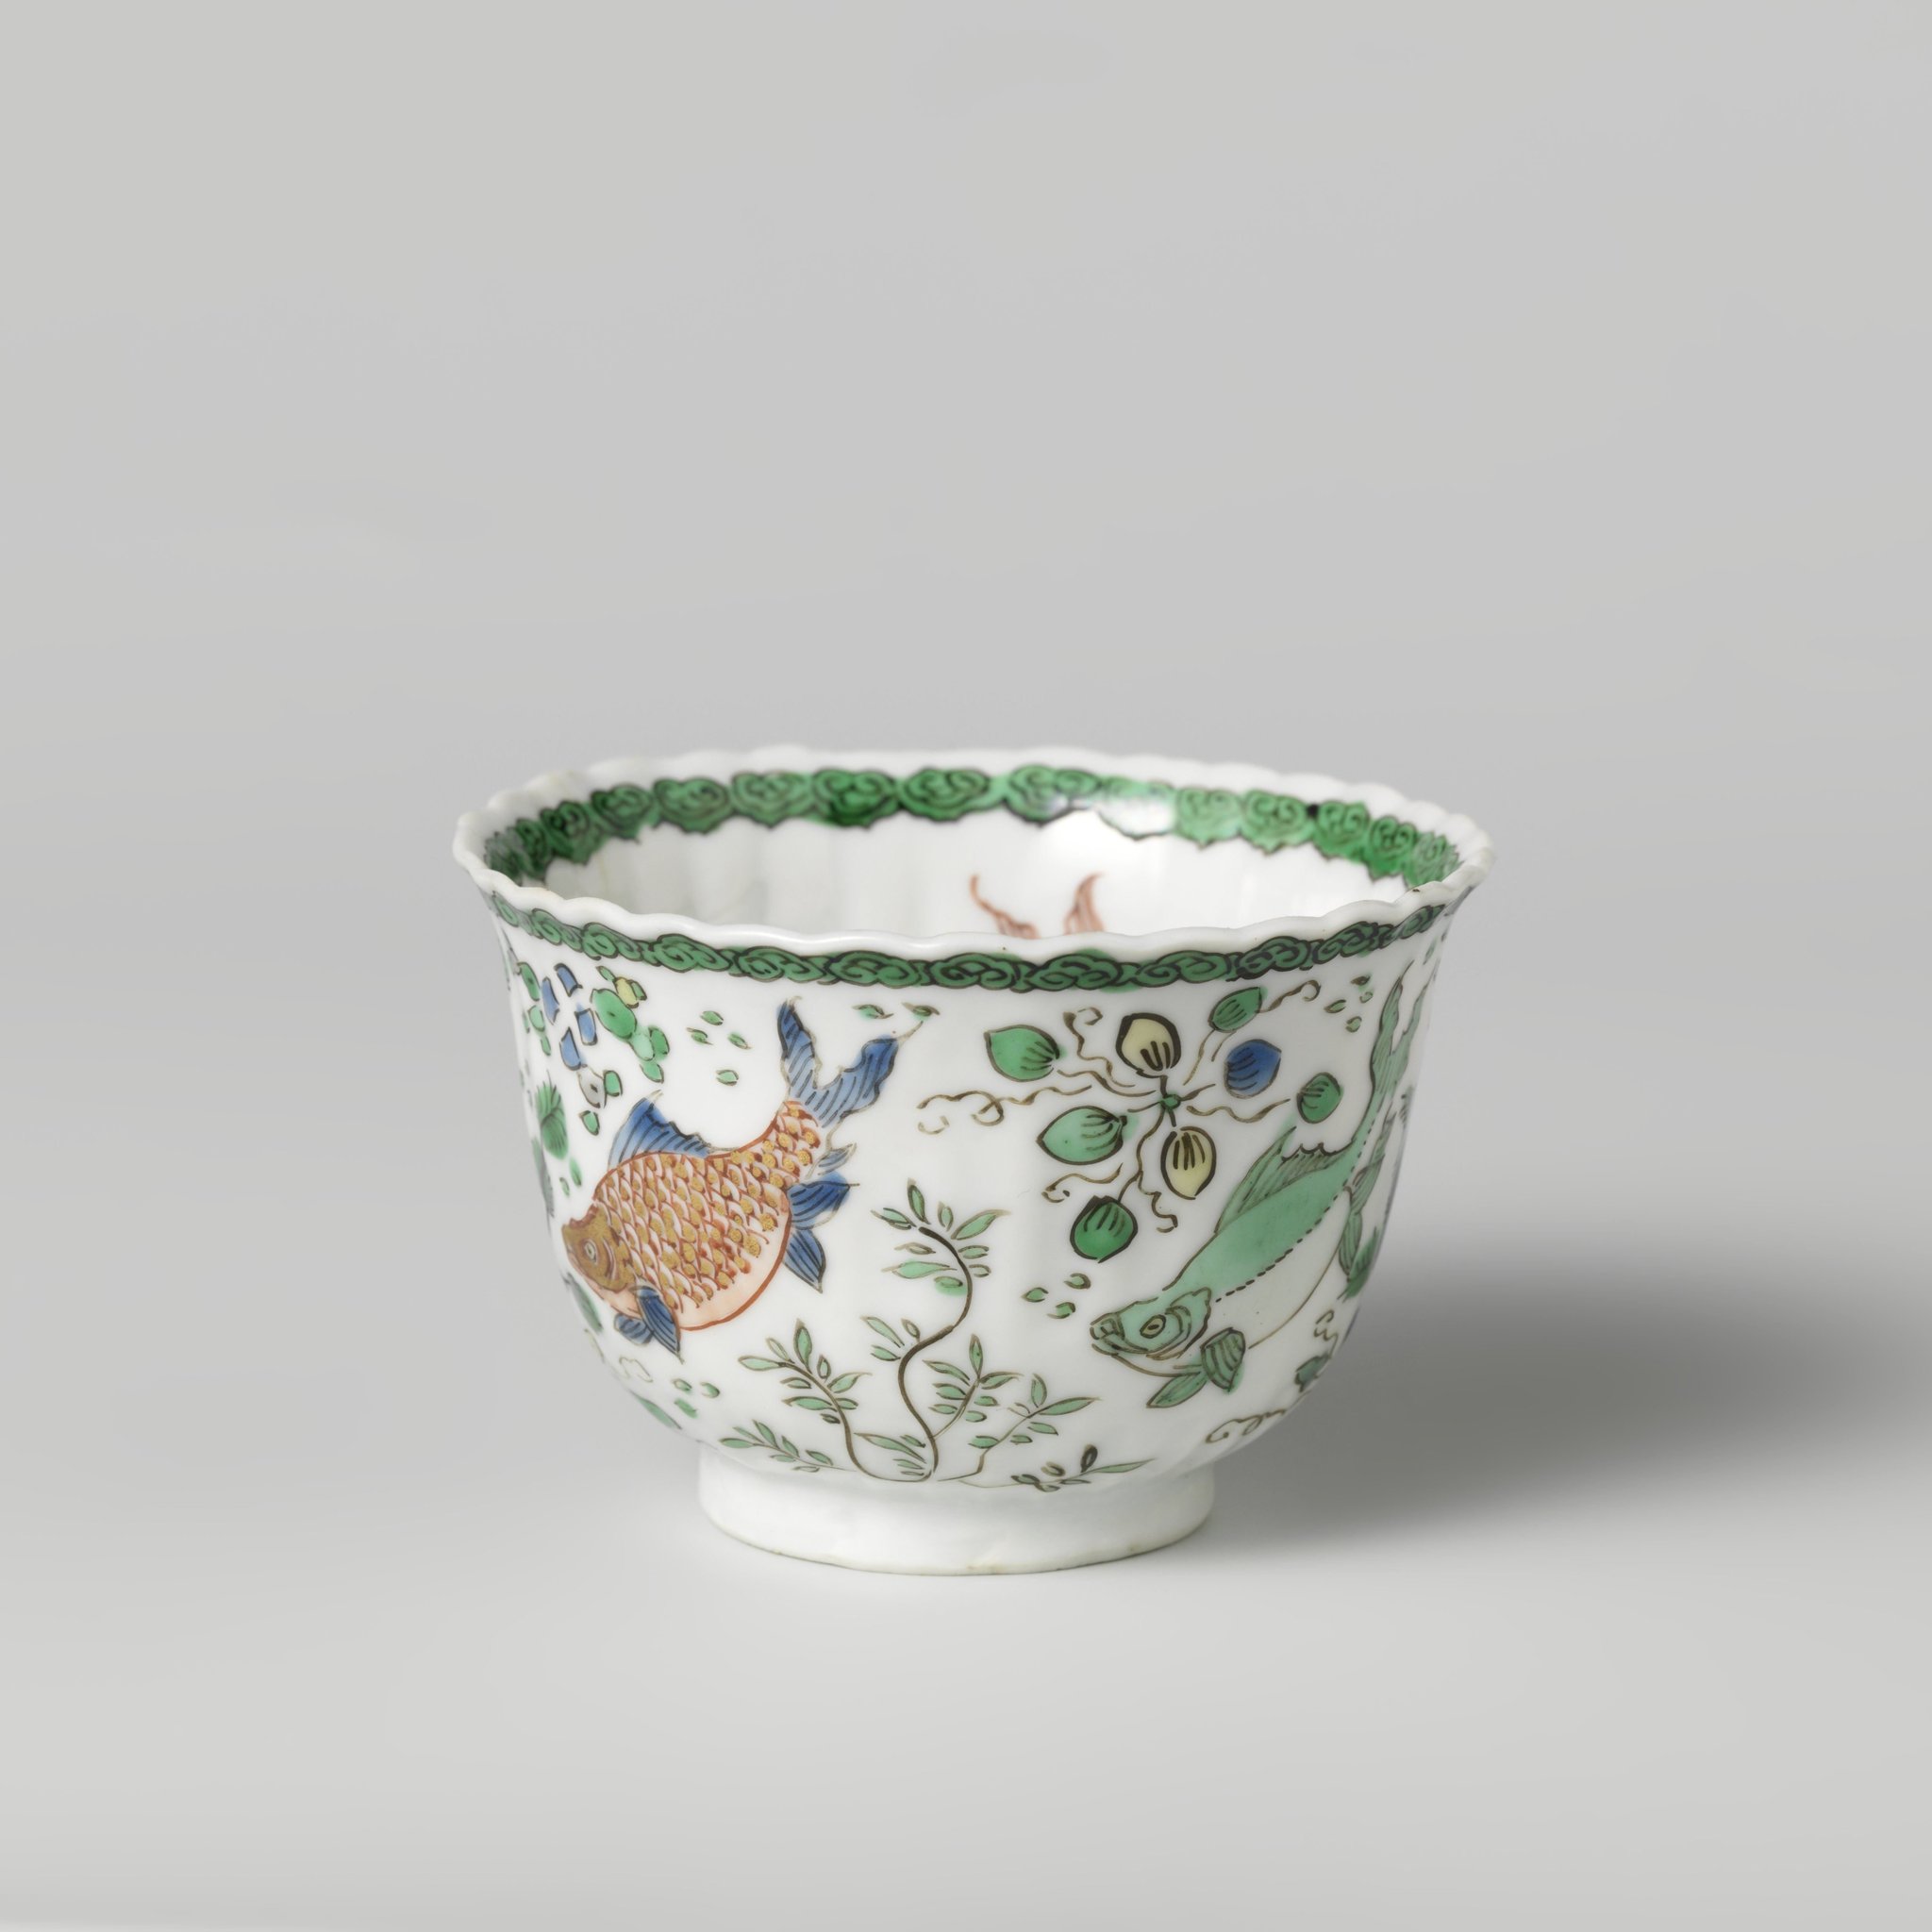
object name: cup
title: Cup with fish between water plants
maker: Anonymous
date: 1700-1724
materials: cobalt, glaze, gold, paint, porcelain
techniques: firing, turning, vitrification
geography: china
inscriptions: mark: ‘玉’, label: ‘A. Staa/ 1645/ BK8st’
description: Kop van porselein met geribde wand en gelobde rand, beschilderd in onderglazuur blauw en op het glazuur blauw, rood, groen, geel, aubergine, zwart en goud. De buitenzijde van de kop met vier vissen tussen waterplanten, de rand met een band ruyi-motief; op de bodem een vis en de binnenzijde met vier vissen in ijzerrood, de rand met een band ruyi-motief. Gemerkt op de onderzijde met 'Yù', jade, in een dubbele cirkel. Twee barsten in de wand van de kop. Oud handelaarslabel op de onderzijde. Famille verte.